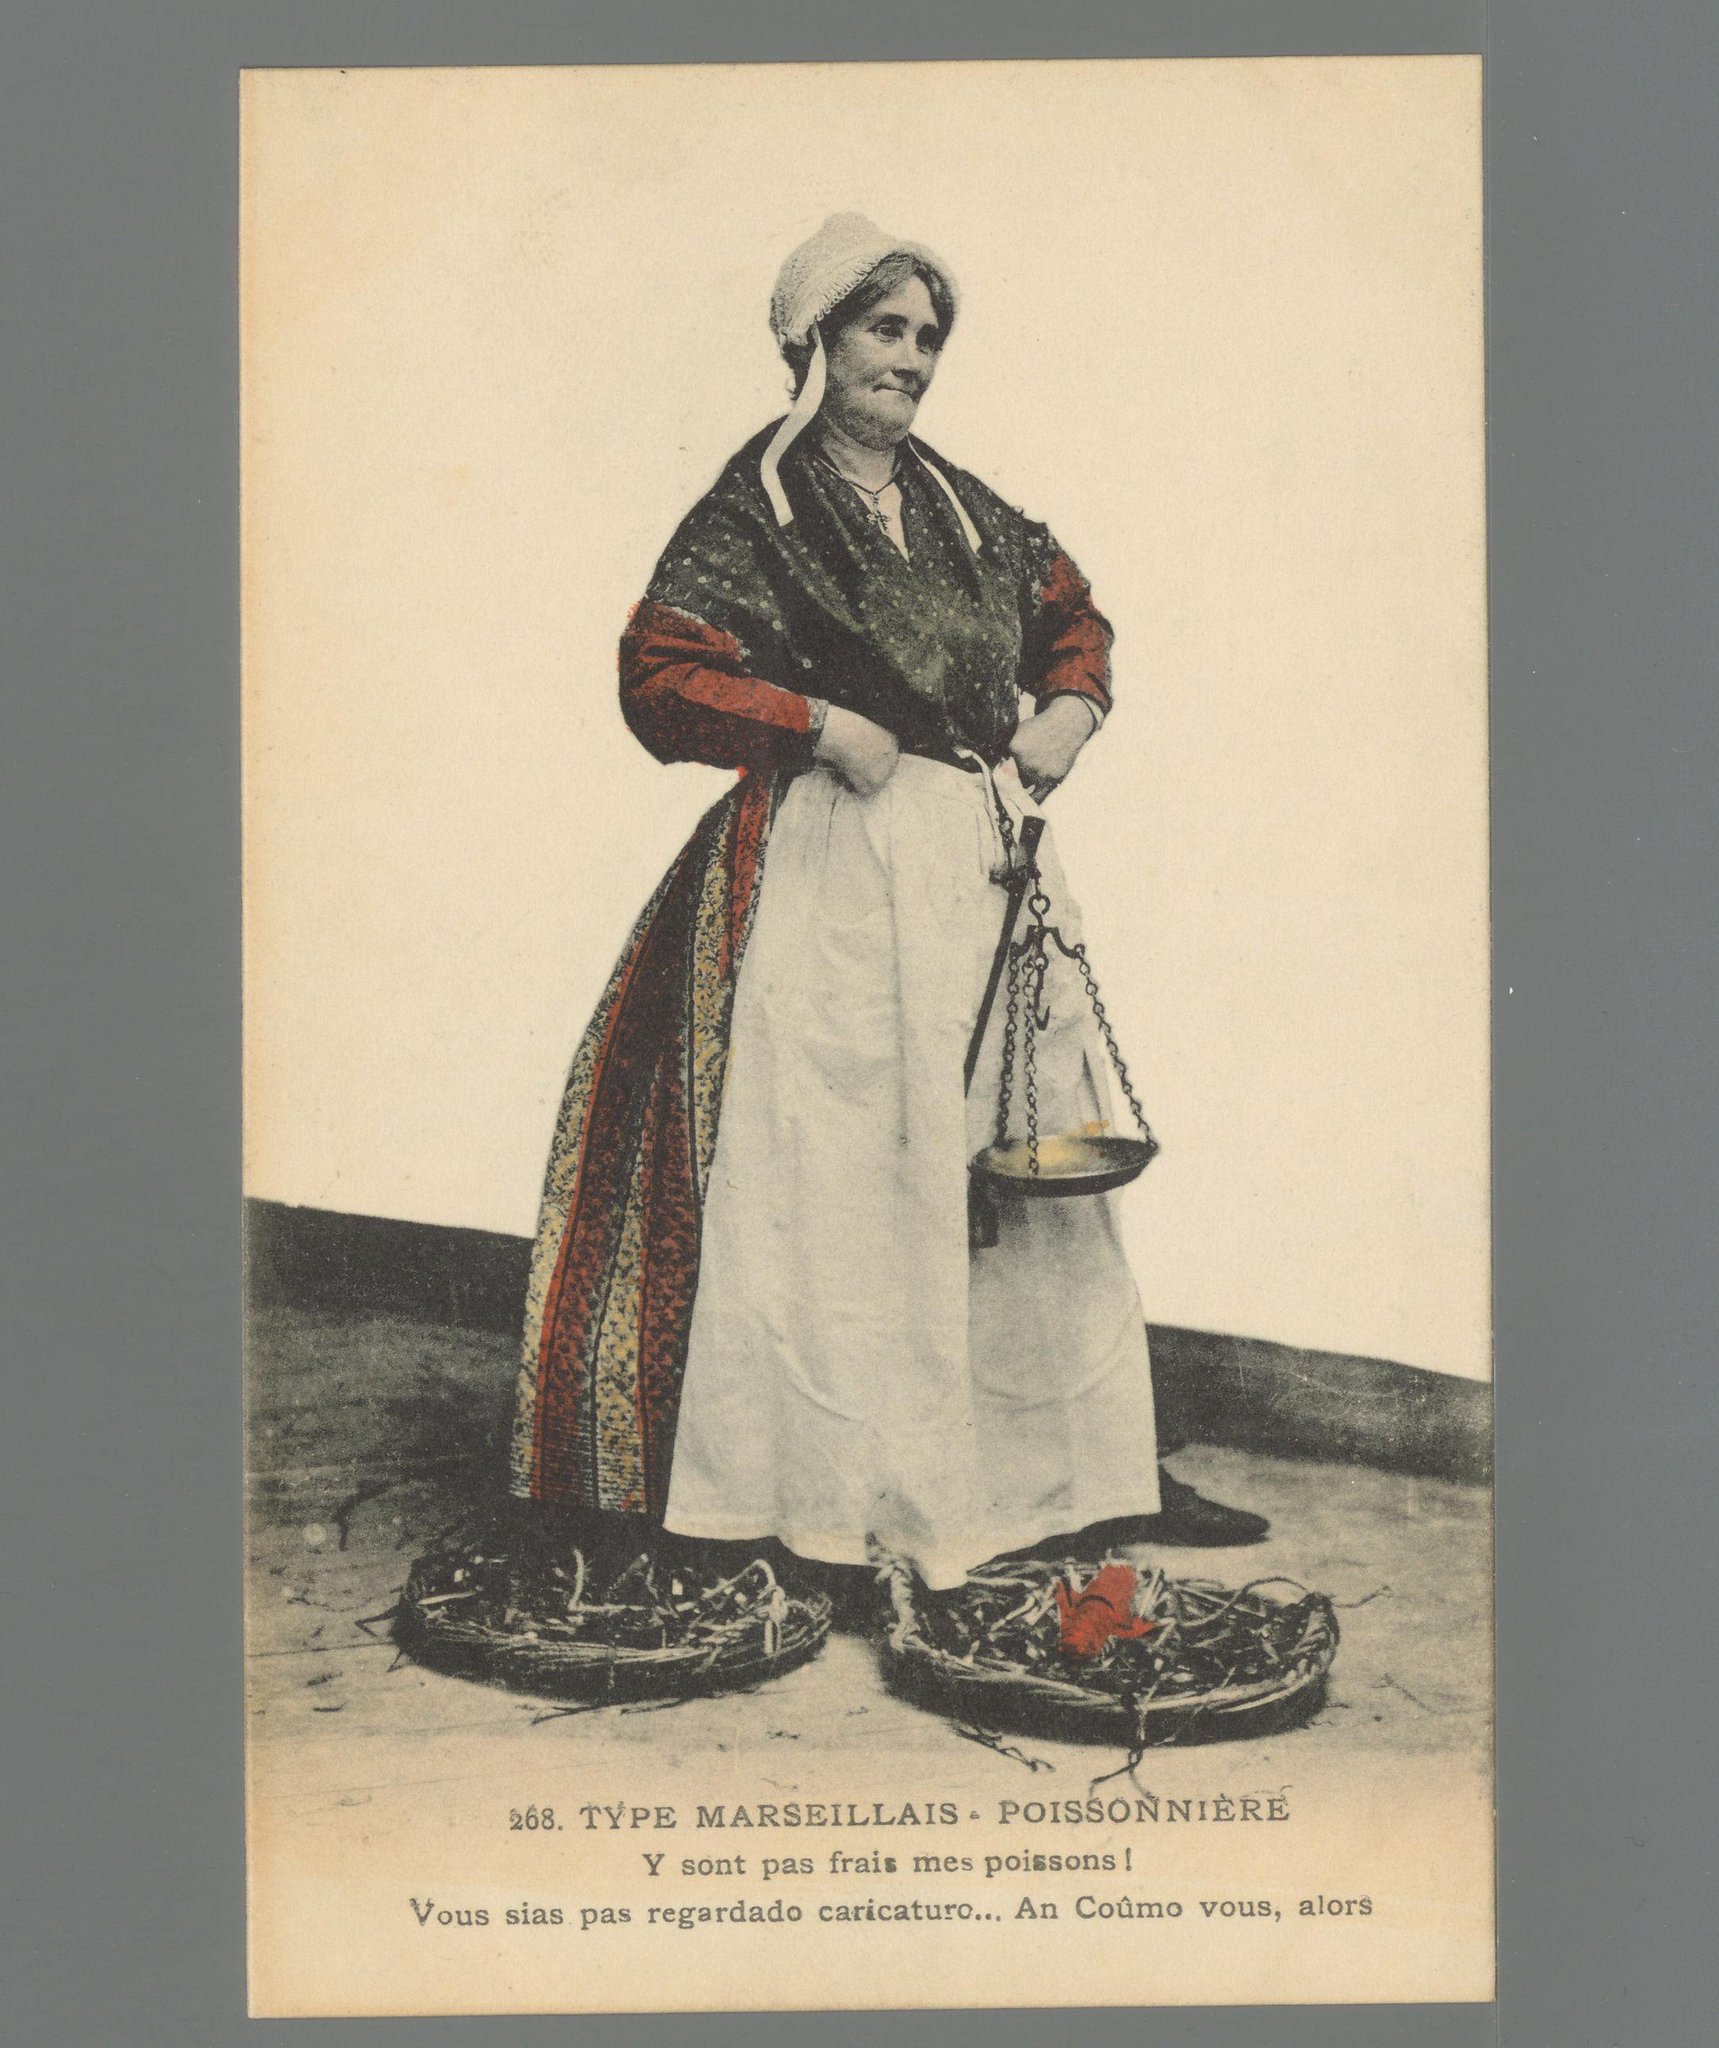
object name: ansichtkaart, prentbriefkaart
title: Poissonnière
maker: Anonymous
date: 1904-1906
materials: cardboard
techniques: photograph, hand coloring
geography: marseille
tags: adult woman, persons engaged in trade and commerce, sea and coastal fishery, marseille